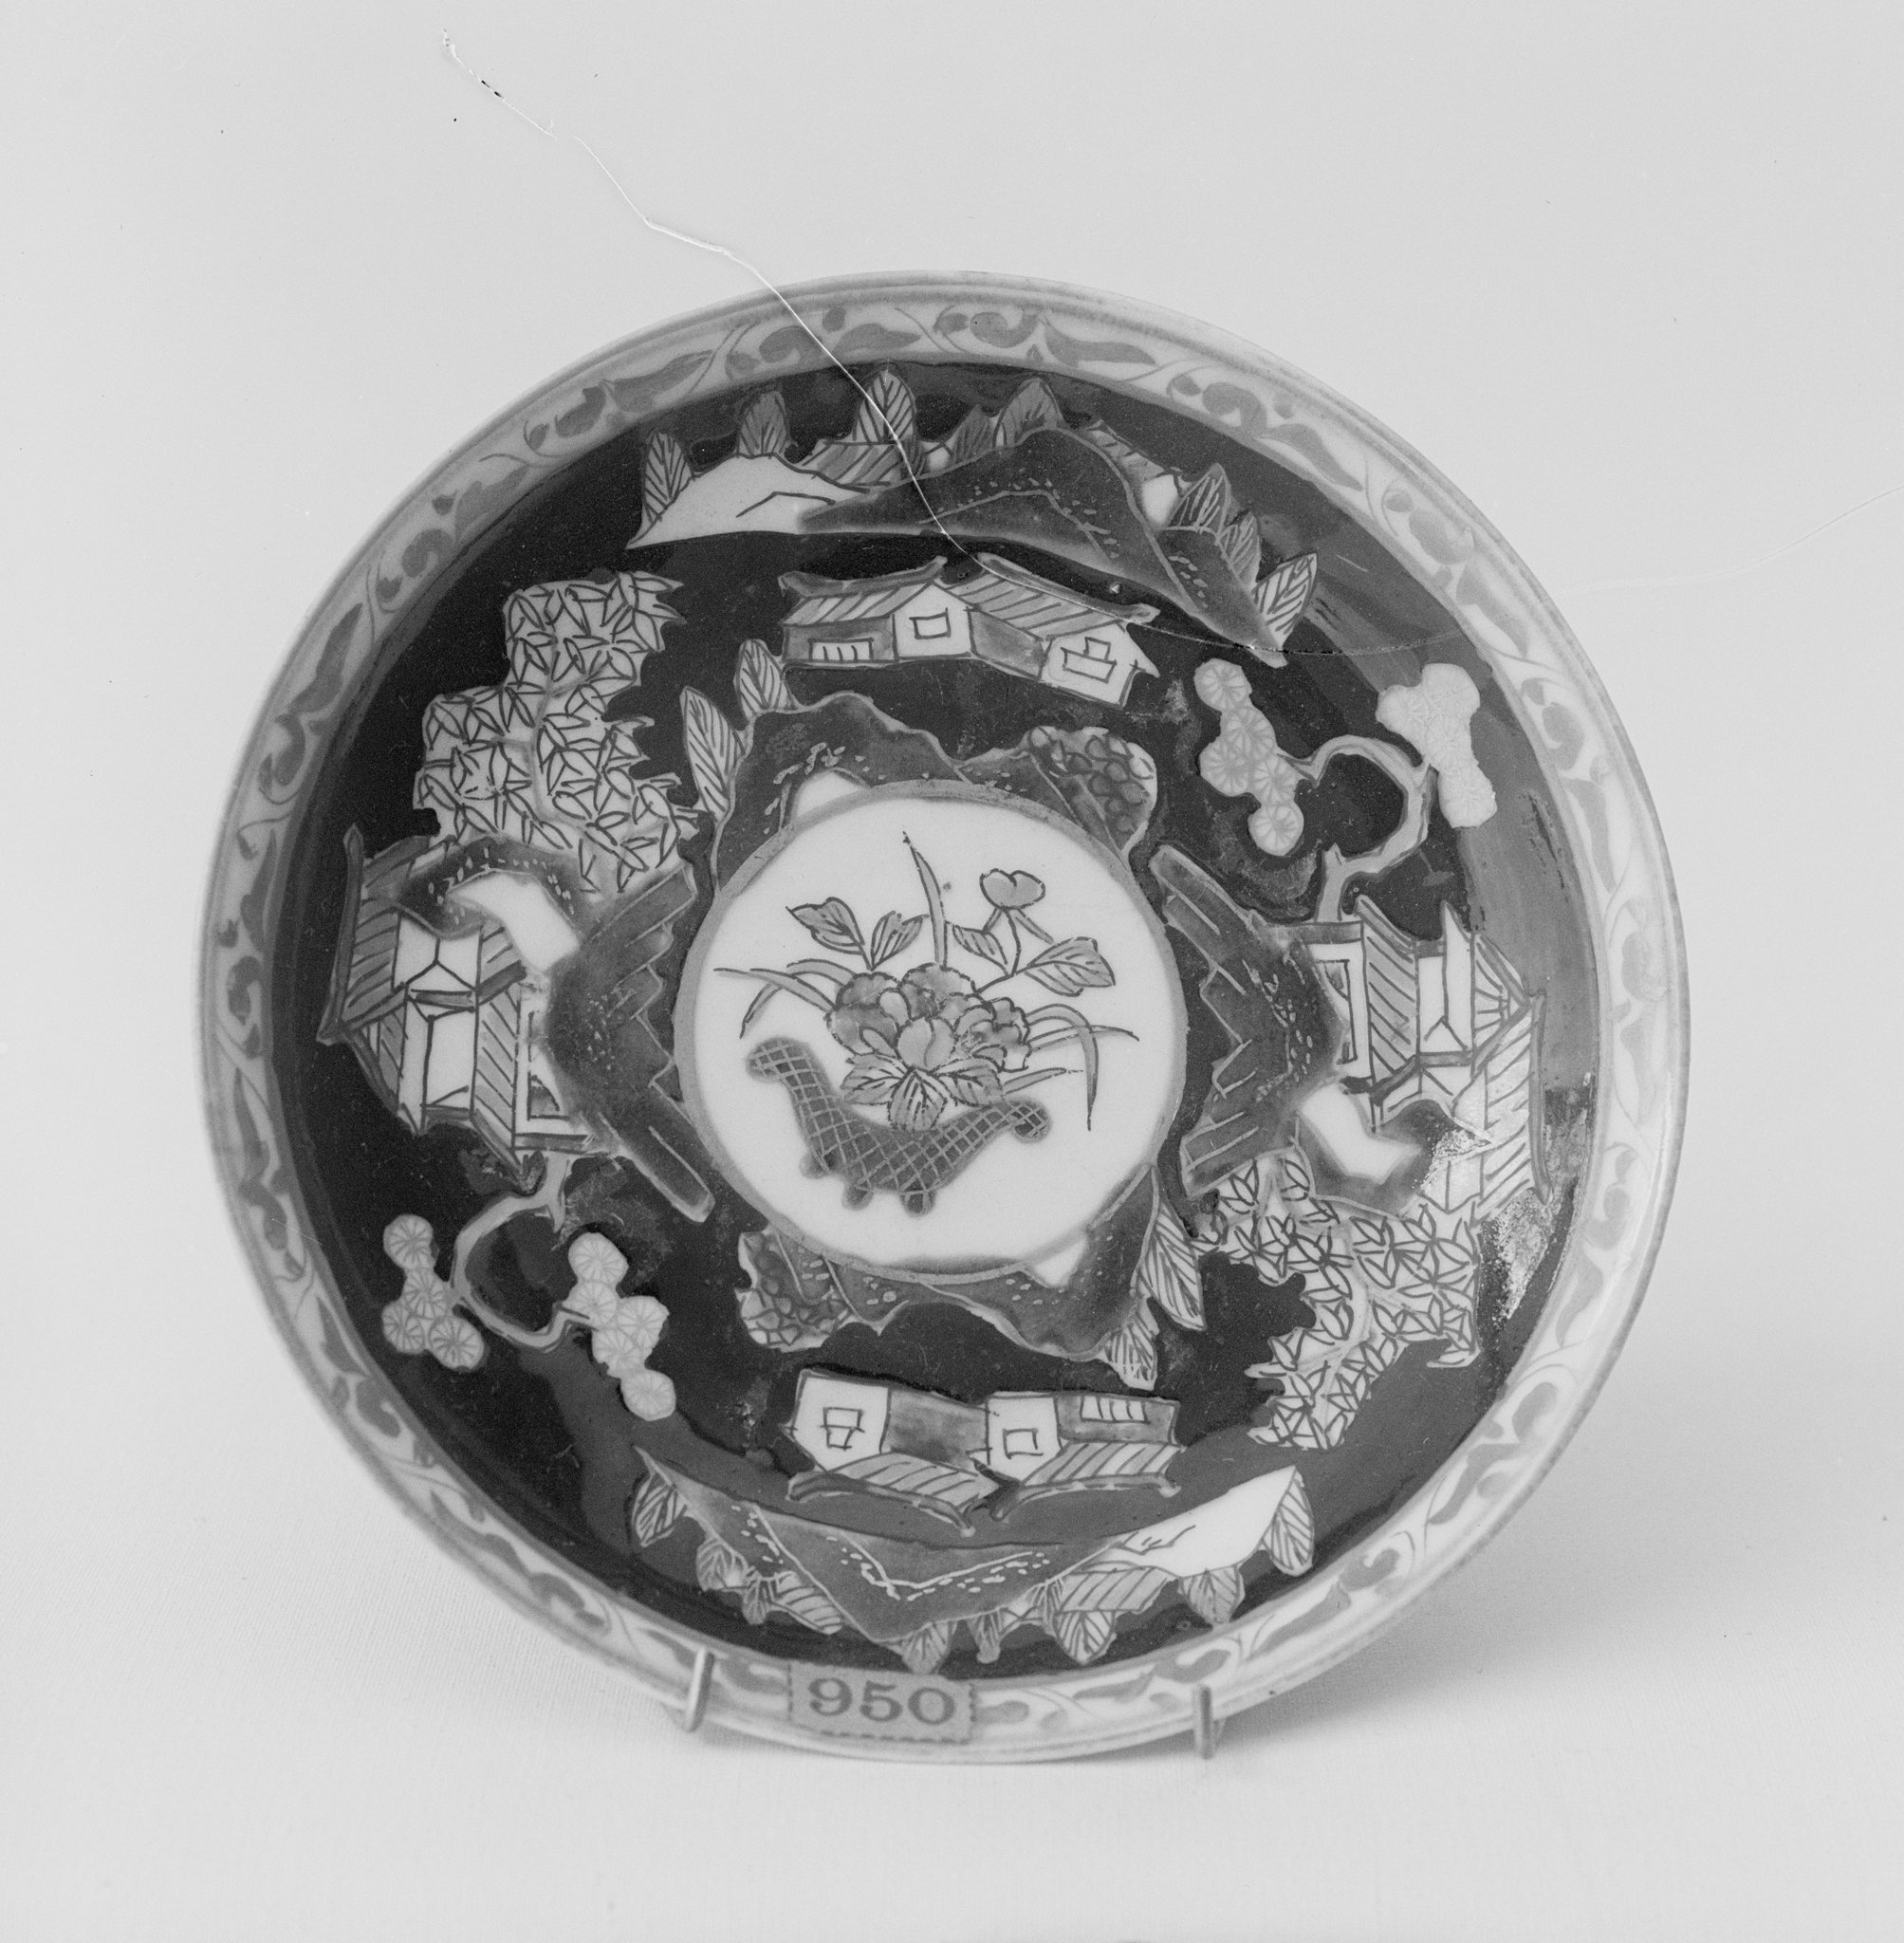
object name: saucer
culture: japanese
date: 1701-1800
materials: glaze, gold, iron, porcelain